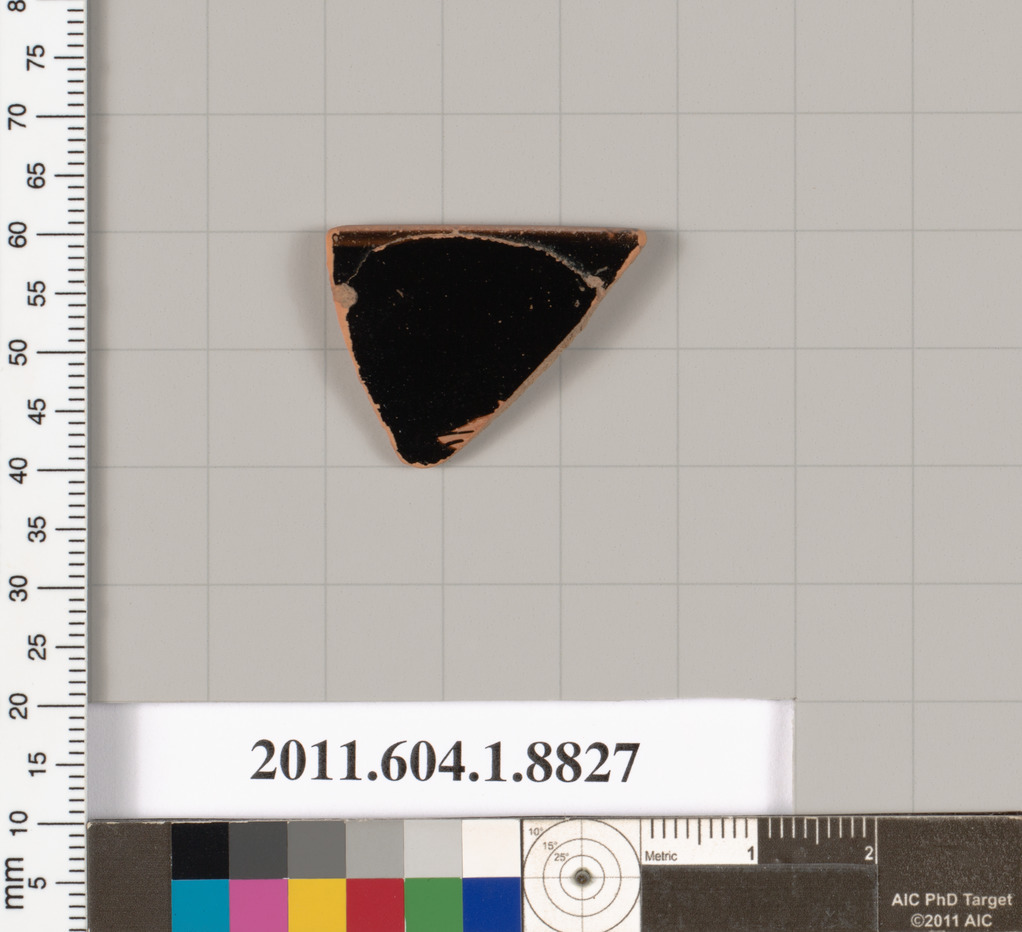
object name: kylix fragment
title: Terracotta rim fragment of a kylix (drinking cup)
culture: greek, attic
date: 500-470 BCE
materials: terracotta